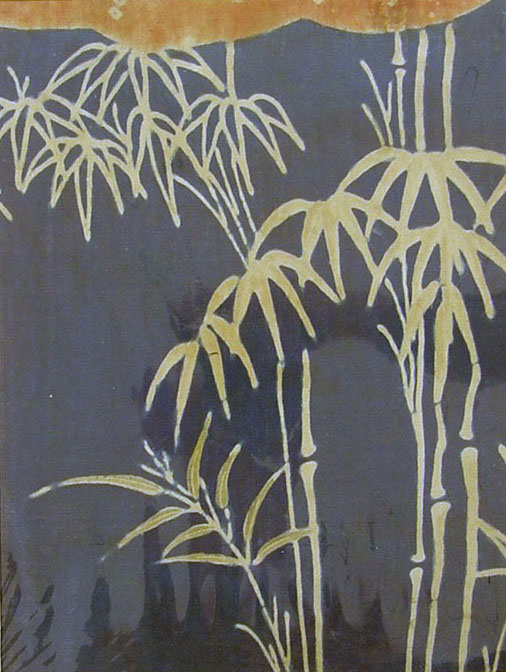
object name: piece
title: Textile with Bamboo and Partial Cloud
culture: japanese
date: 1615-1868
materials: silk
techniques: dyeing, painting, weave, resist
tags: bamboo